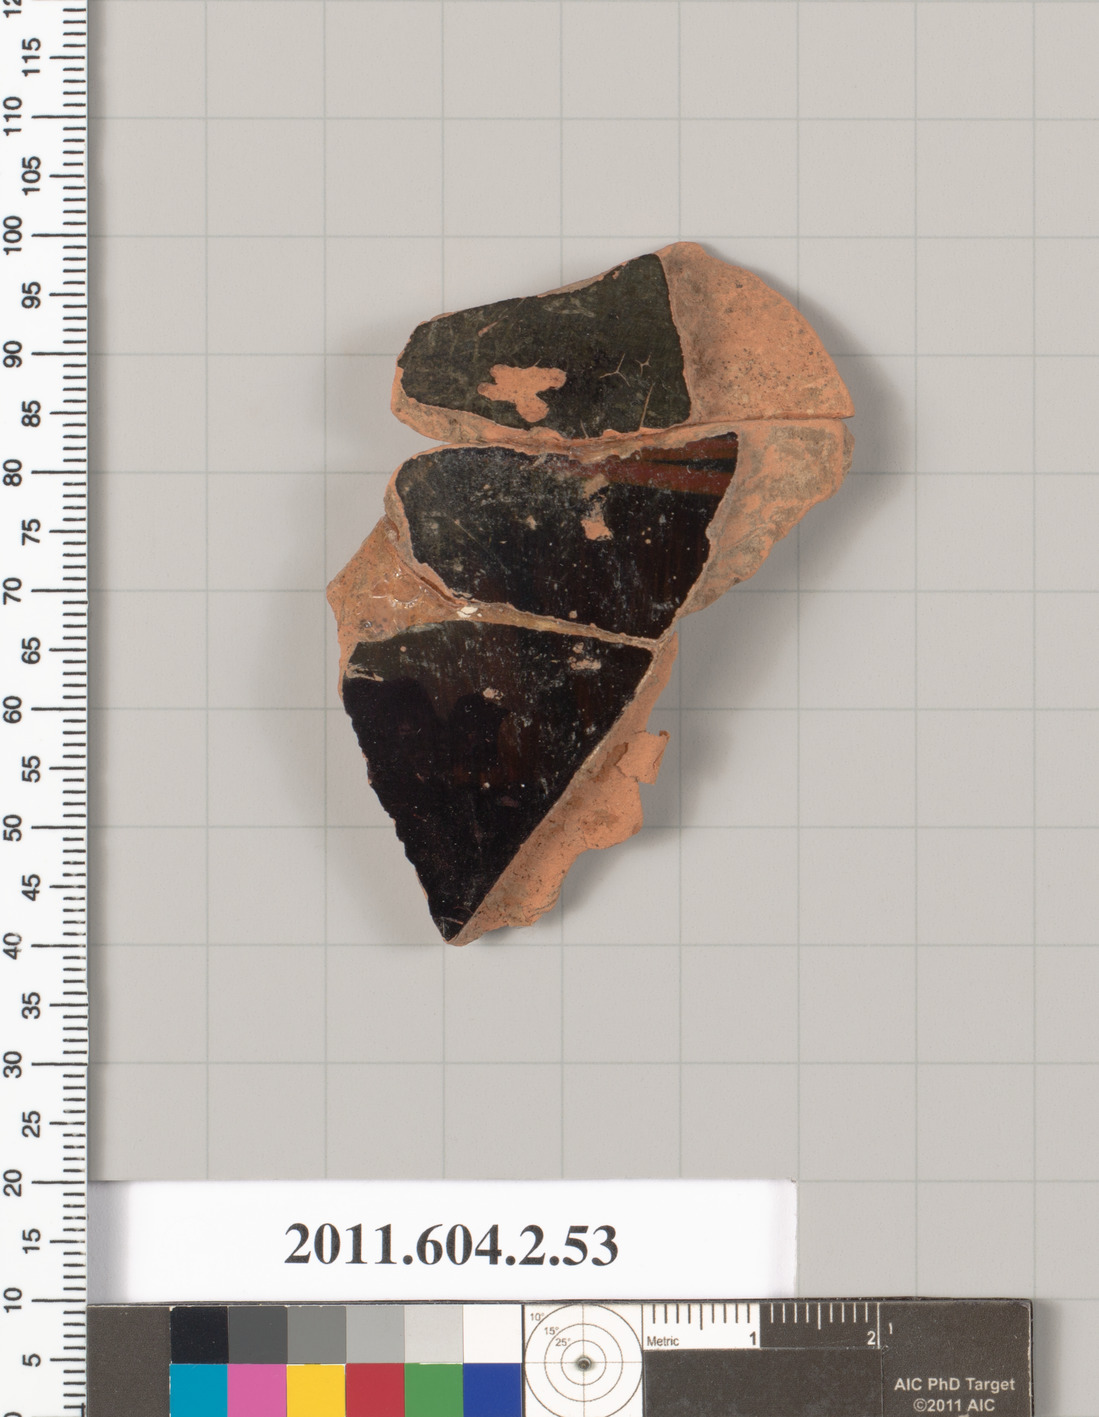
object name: pot fragment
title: Terracotta fragment of a pot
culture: greek, attic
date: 510-480 BCE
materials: terracotta